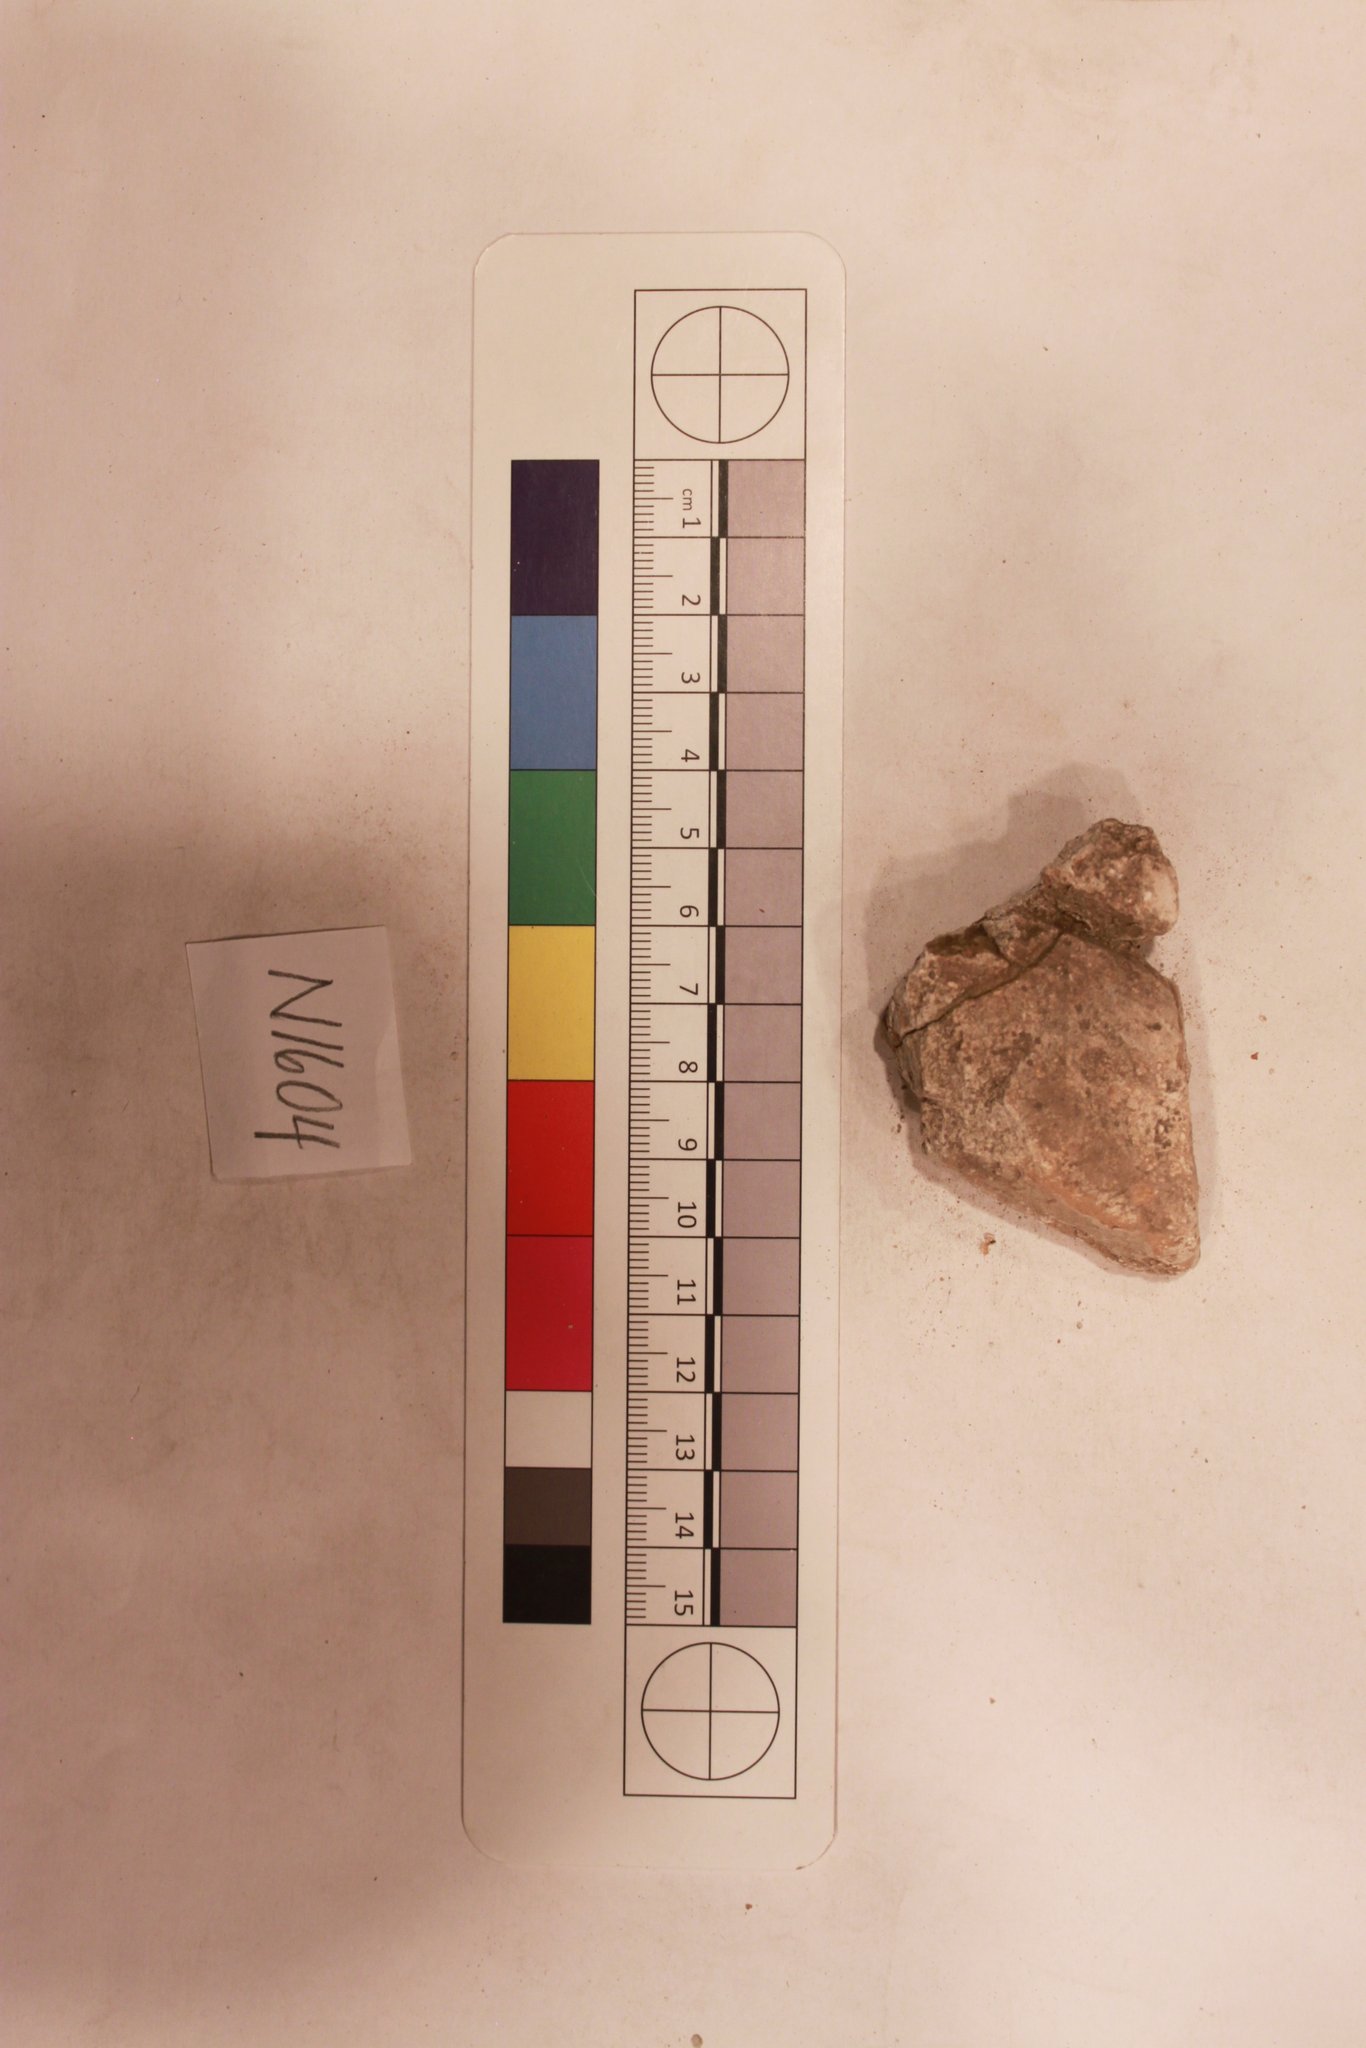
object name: fragment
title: Stucco Fragment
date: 701-1200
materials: plaster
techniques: carving, painting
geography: iran